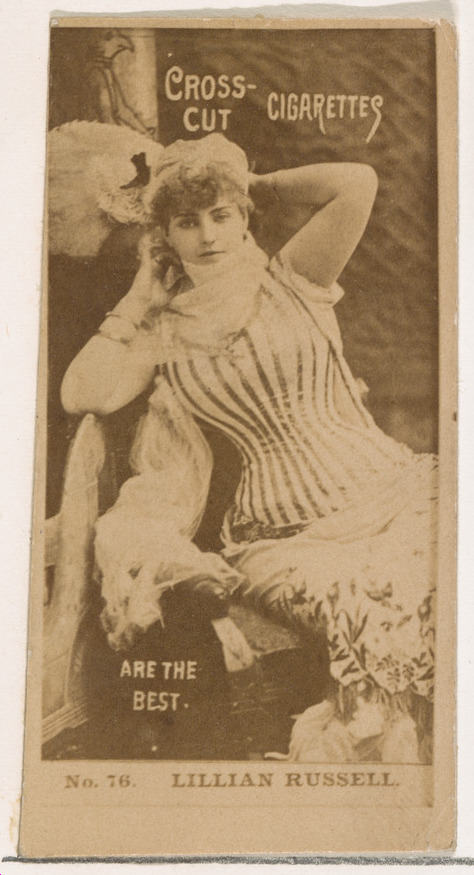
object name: print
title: Card Number 76, Lillian Russell, from the Actors and Actresses series (N145-2) issued by Duke Sons & Co. to promote Cross Cut Cigarettes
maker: w. duke, sons & co.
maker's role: publisher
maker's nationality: american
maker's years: 1870-1920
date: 1880-1889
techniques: albumen silver print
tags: portraits,women,actresses